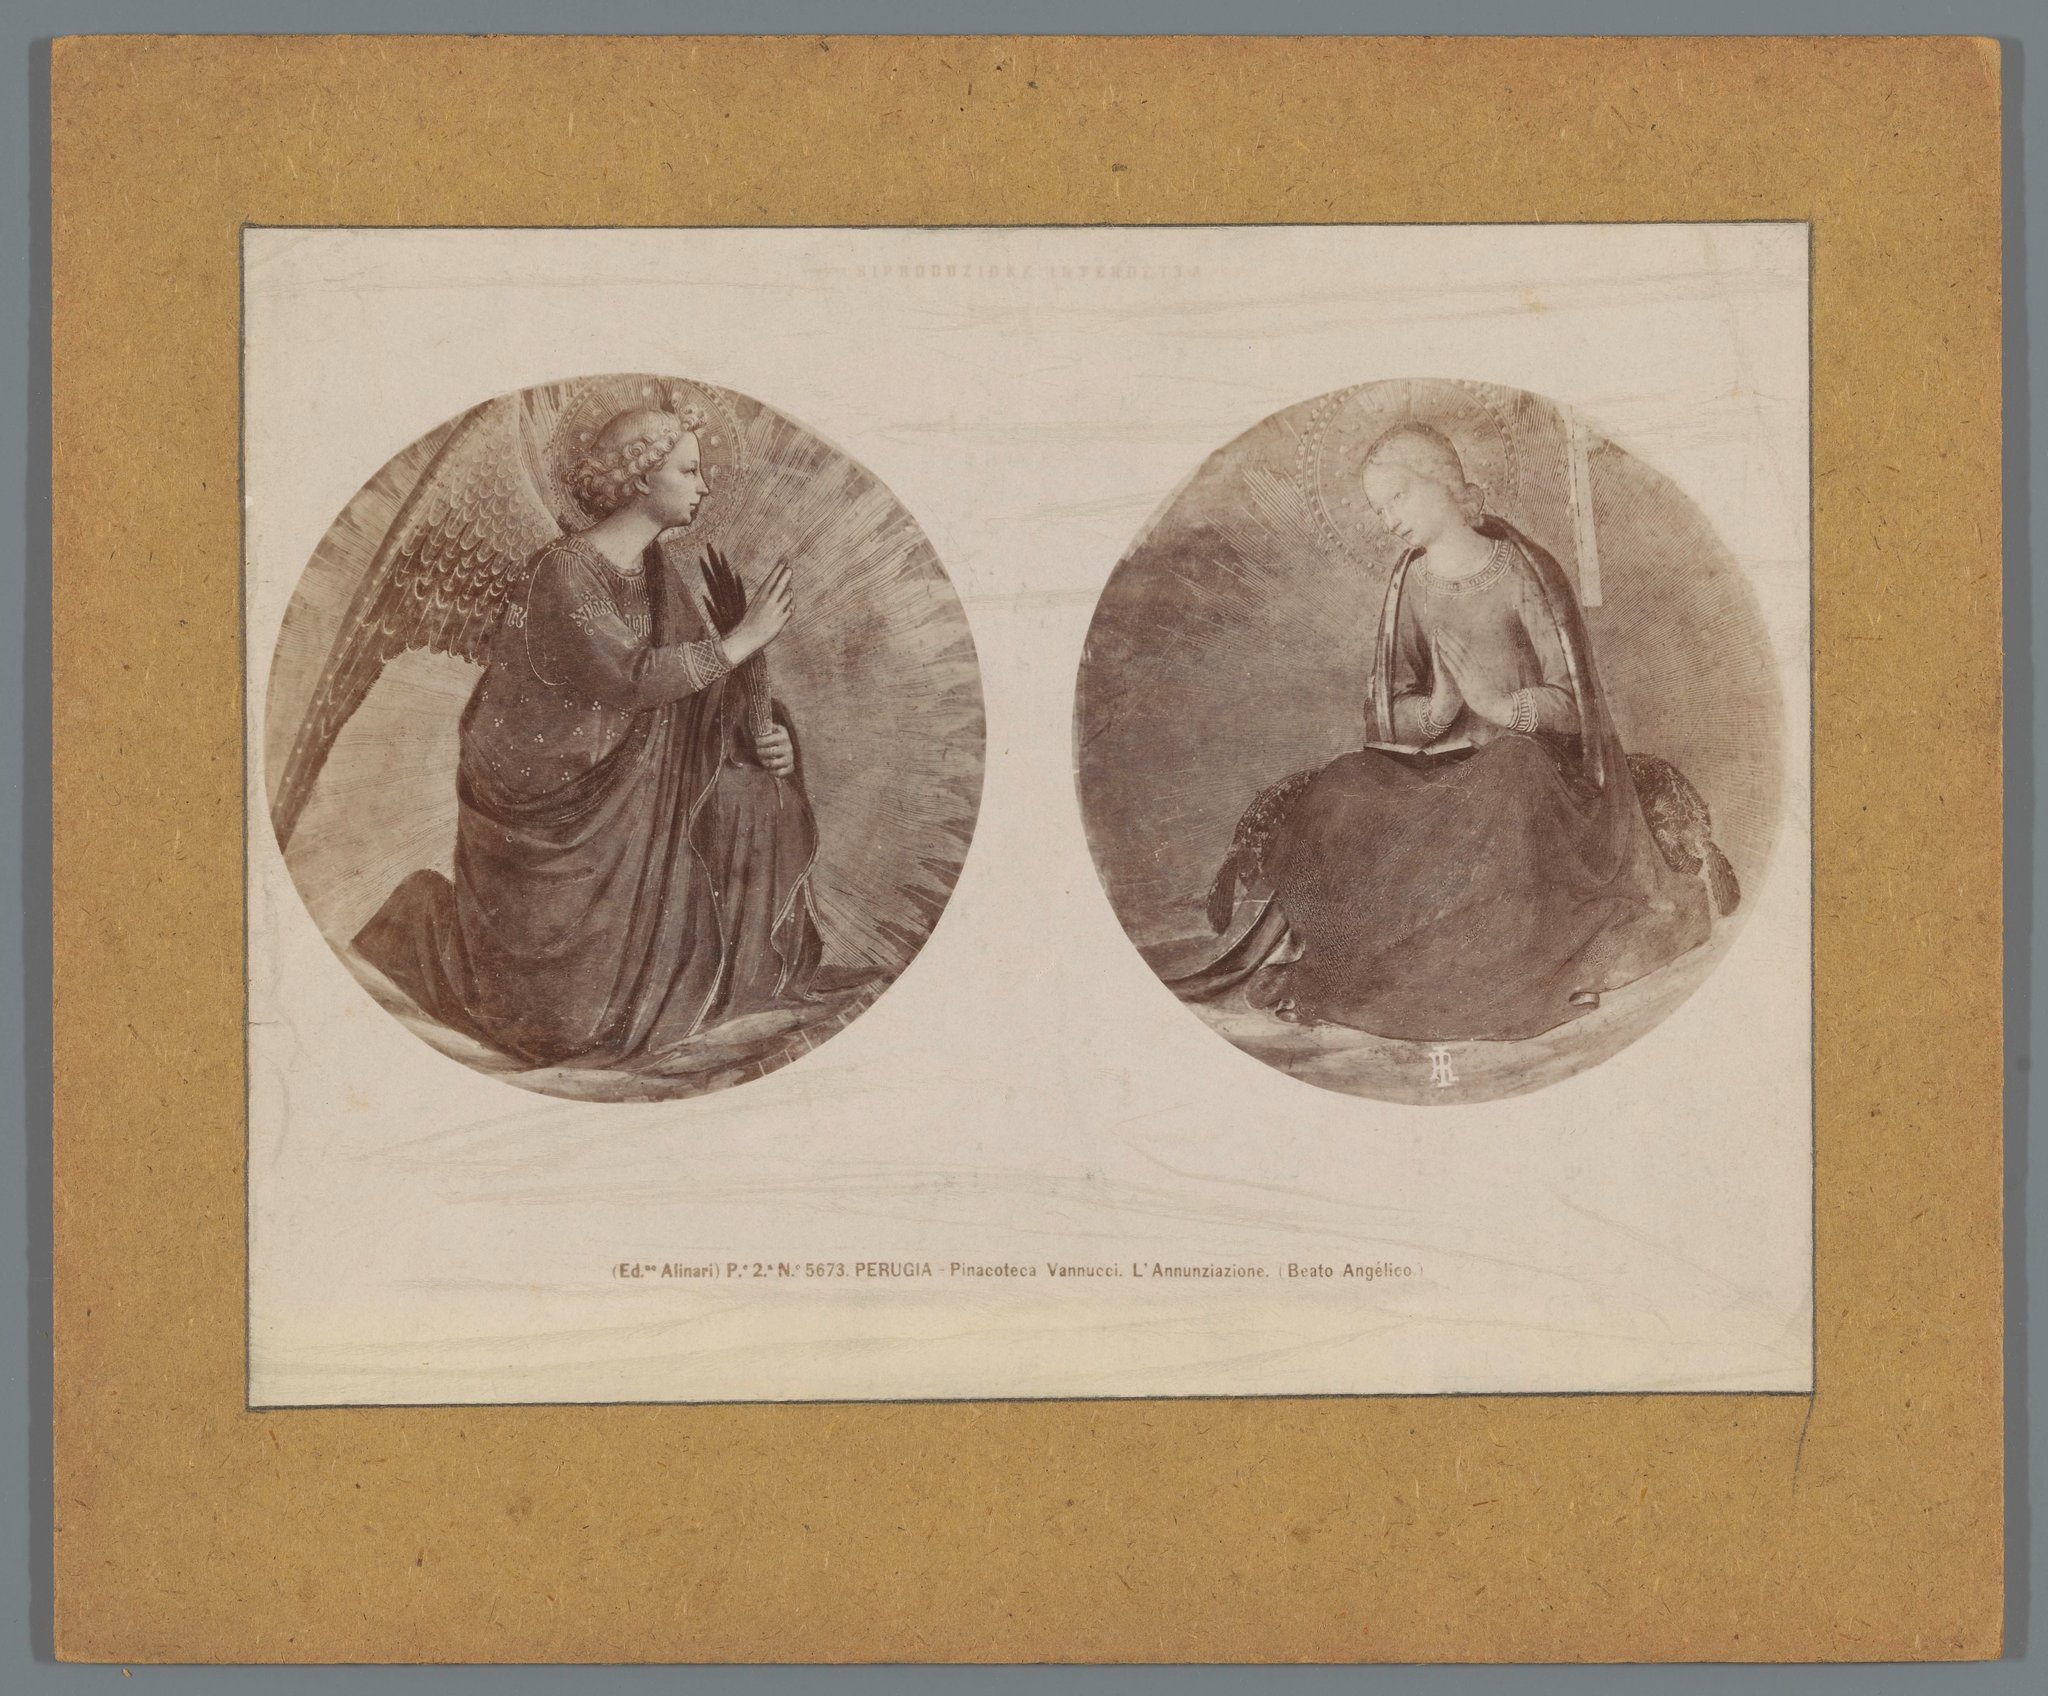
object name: photograph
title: PERUGIA - Pinacoteca Vannucci. L'Annunziazione.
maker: fra angelico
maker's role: painter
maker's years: 1400-1455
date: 1875-1900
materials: cardboard, photographic support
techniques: albumen print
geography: galleria nazionale dell'umbria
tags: the annunciation: mary sitting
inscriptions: collector's mark: Lugt 3937, number: ‘P. 2. N. 5673.’, inscription: